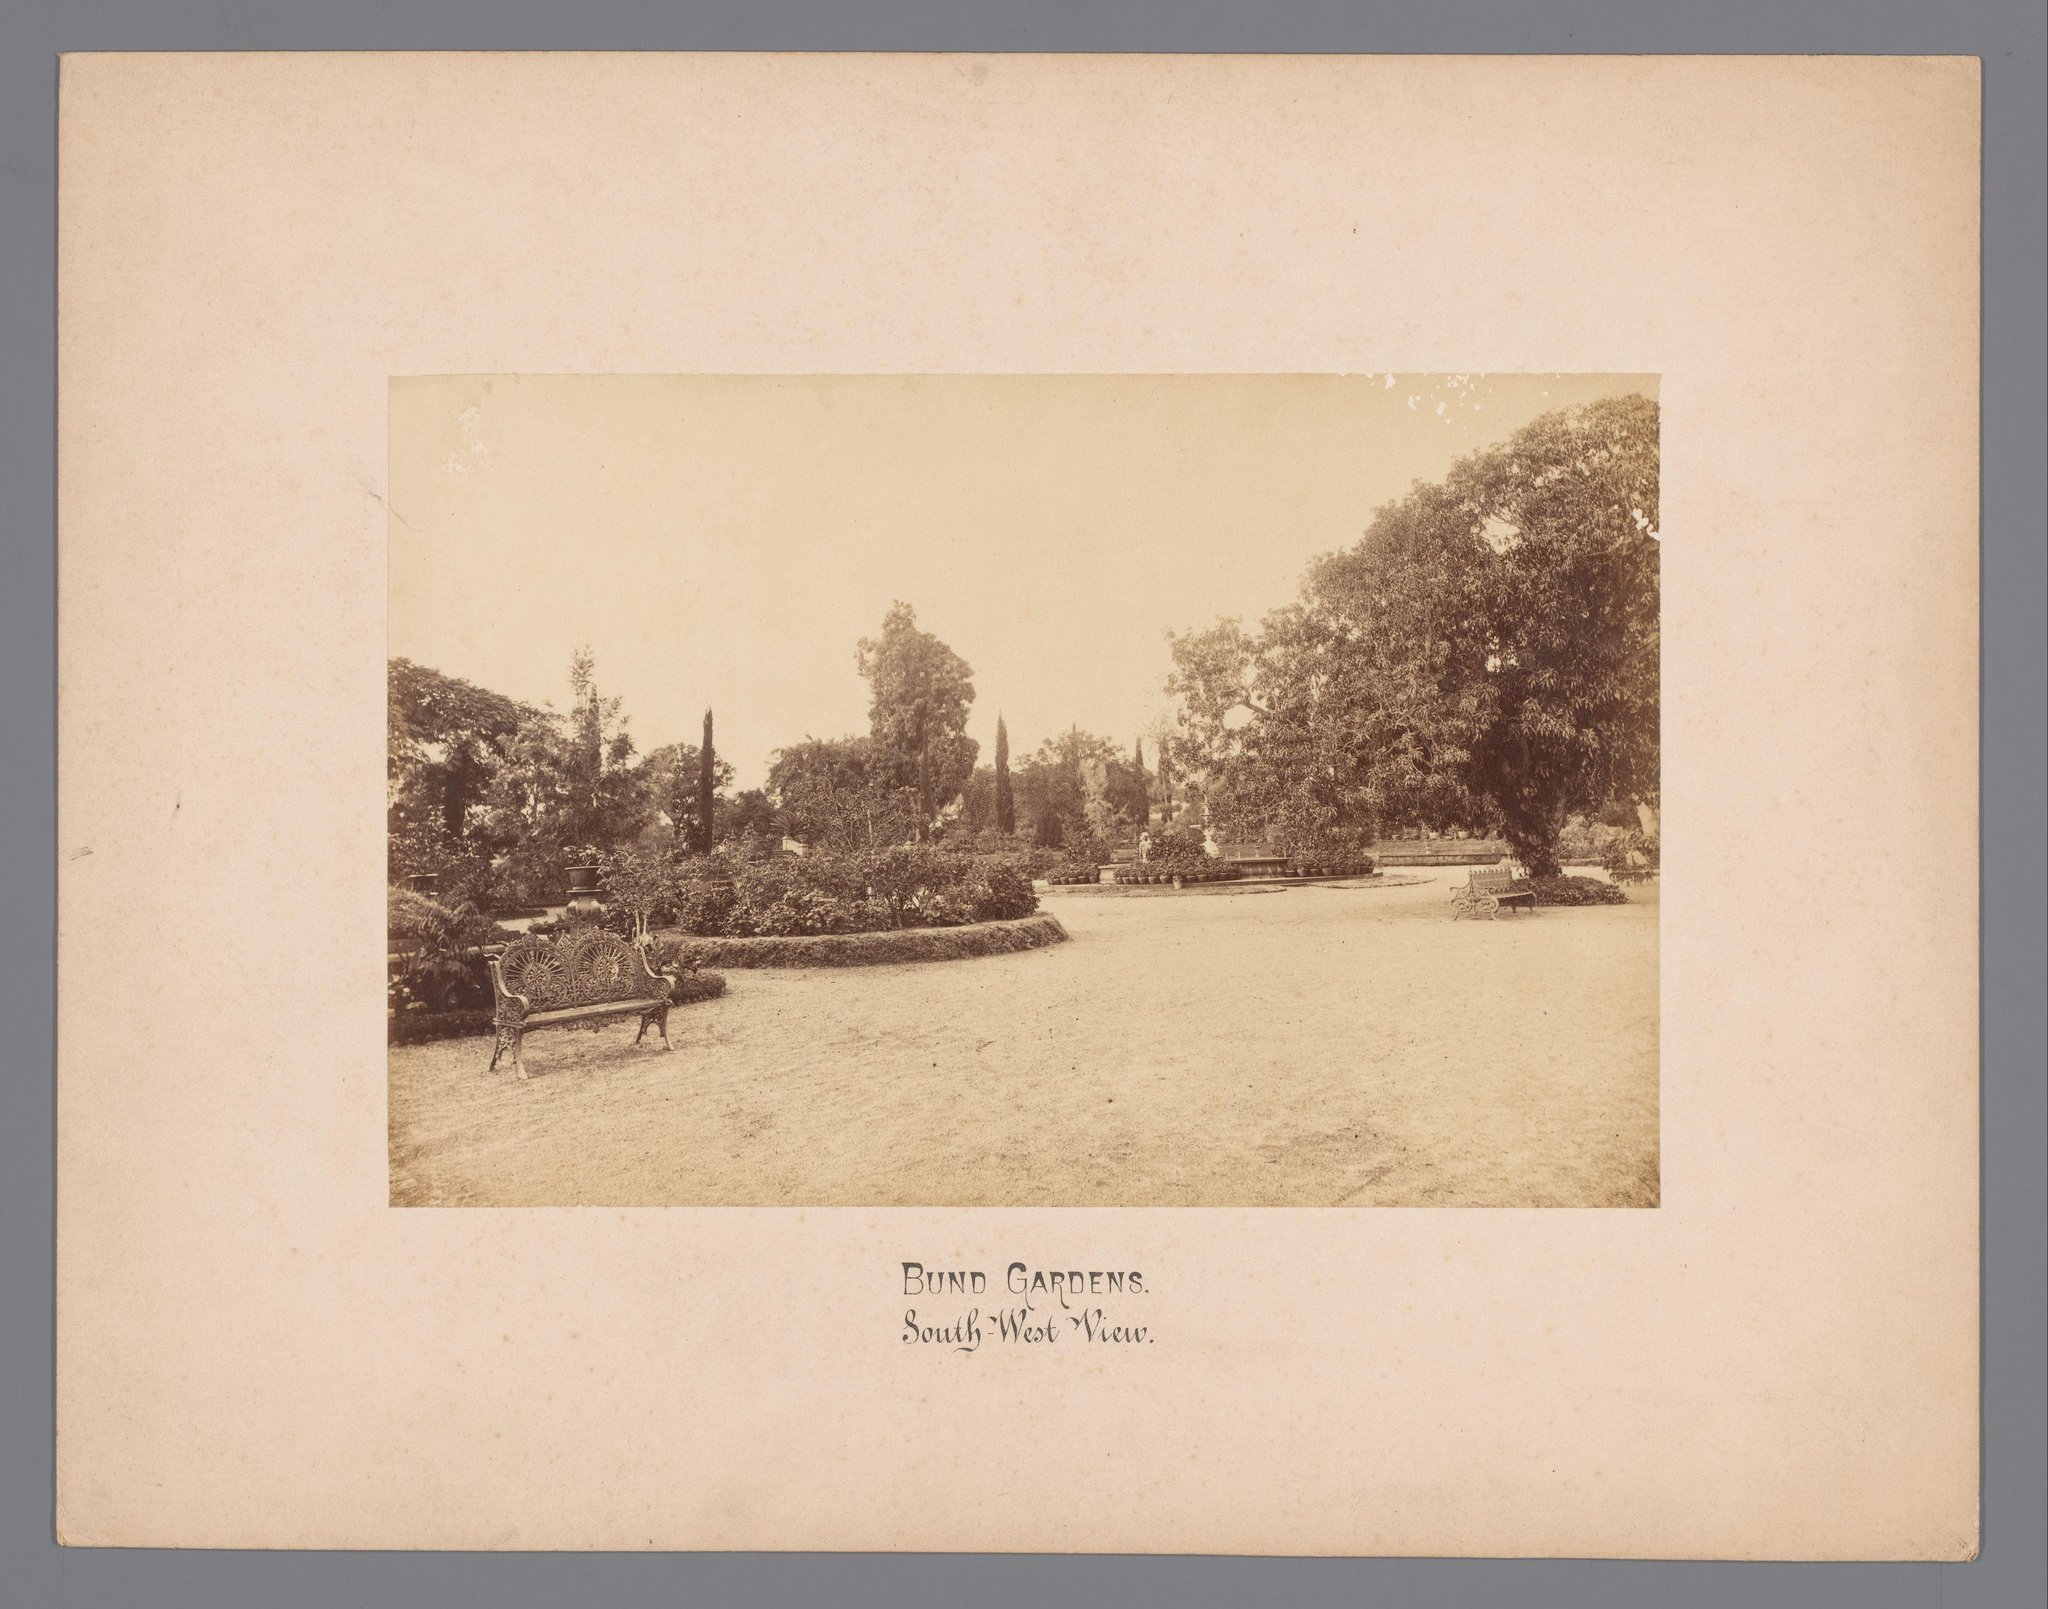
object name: photograph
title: Bund Gardens, Poona, India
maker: Anonymous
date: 1875-1900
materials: cardboard, photographic support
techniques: albumen print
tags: india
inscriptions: inscription: ‘BUND GARDENS, POONA.//South-West View.’, inscription: ‘Bund Gardens//South-West View’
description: Gezicht op een park in Poona, ook wel Pune en Puna en vroeger Punavadi genoemd. Dit is een Indiase stad niet ver van Bombay in de West-Ghats. De stad is gelegen in het gelijknamige district Poona.